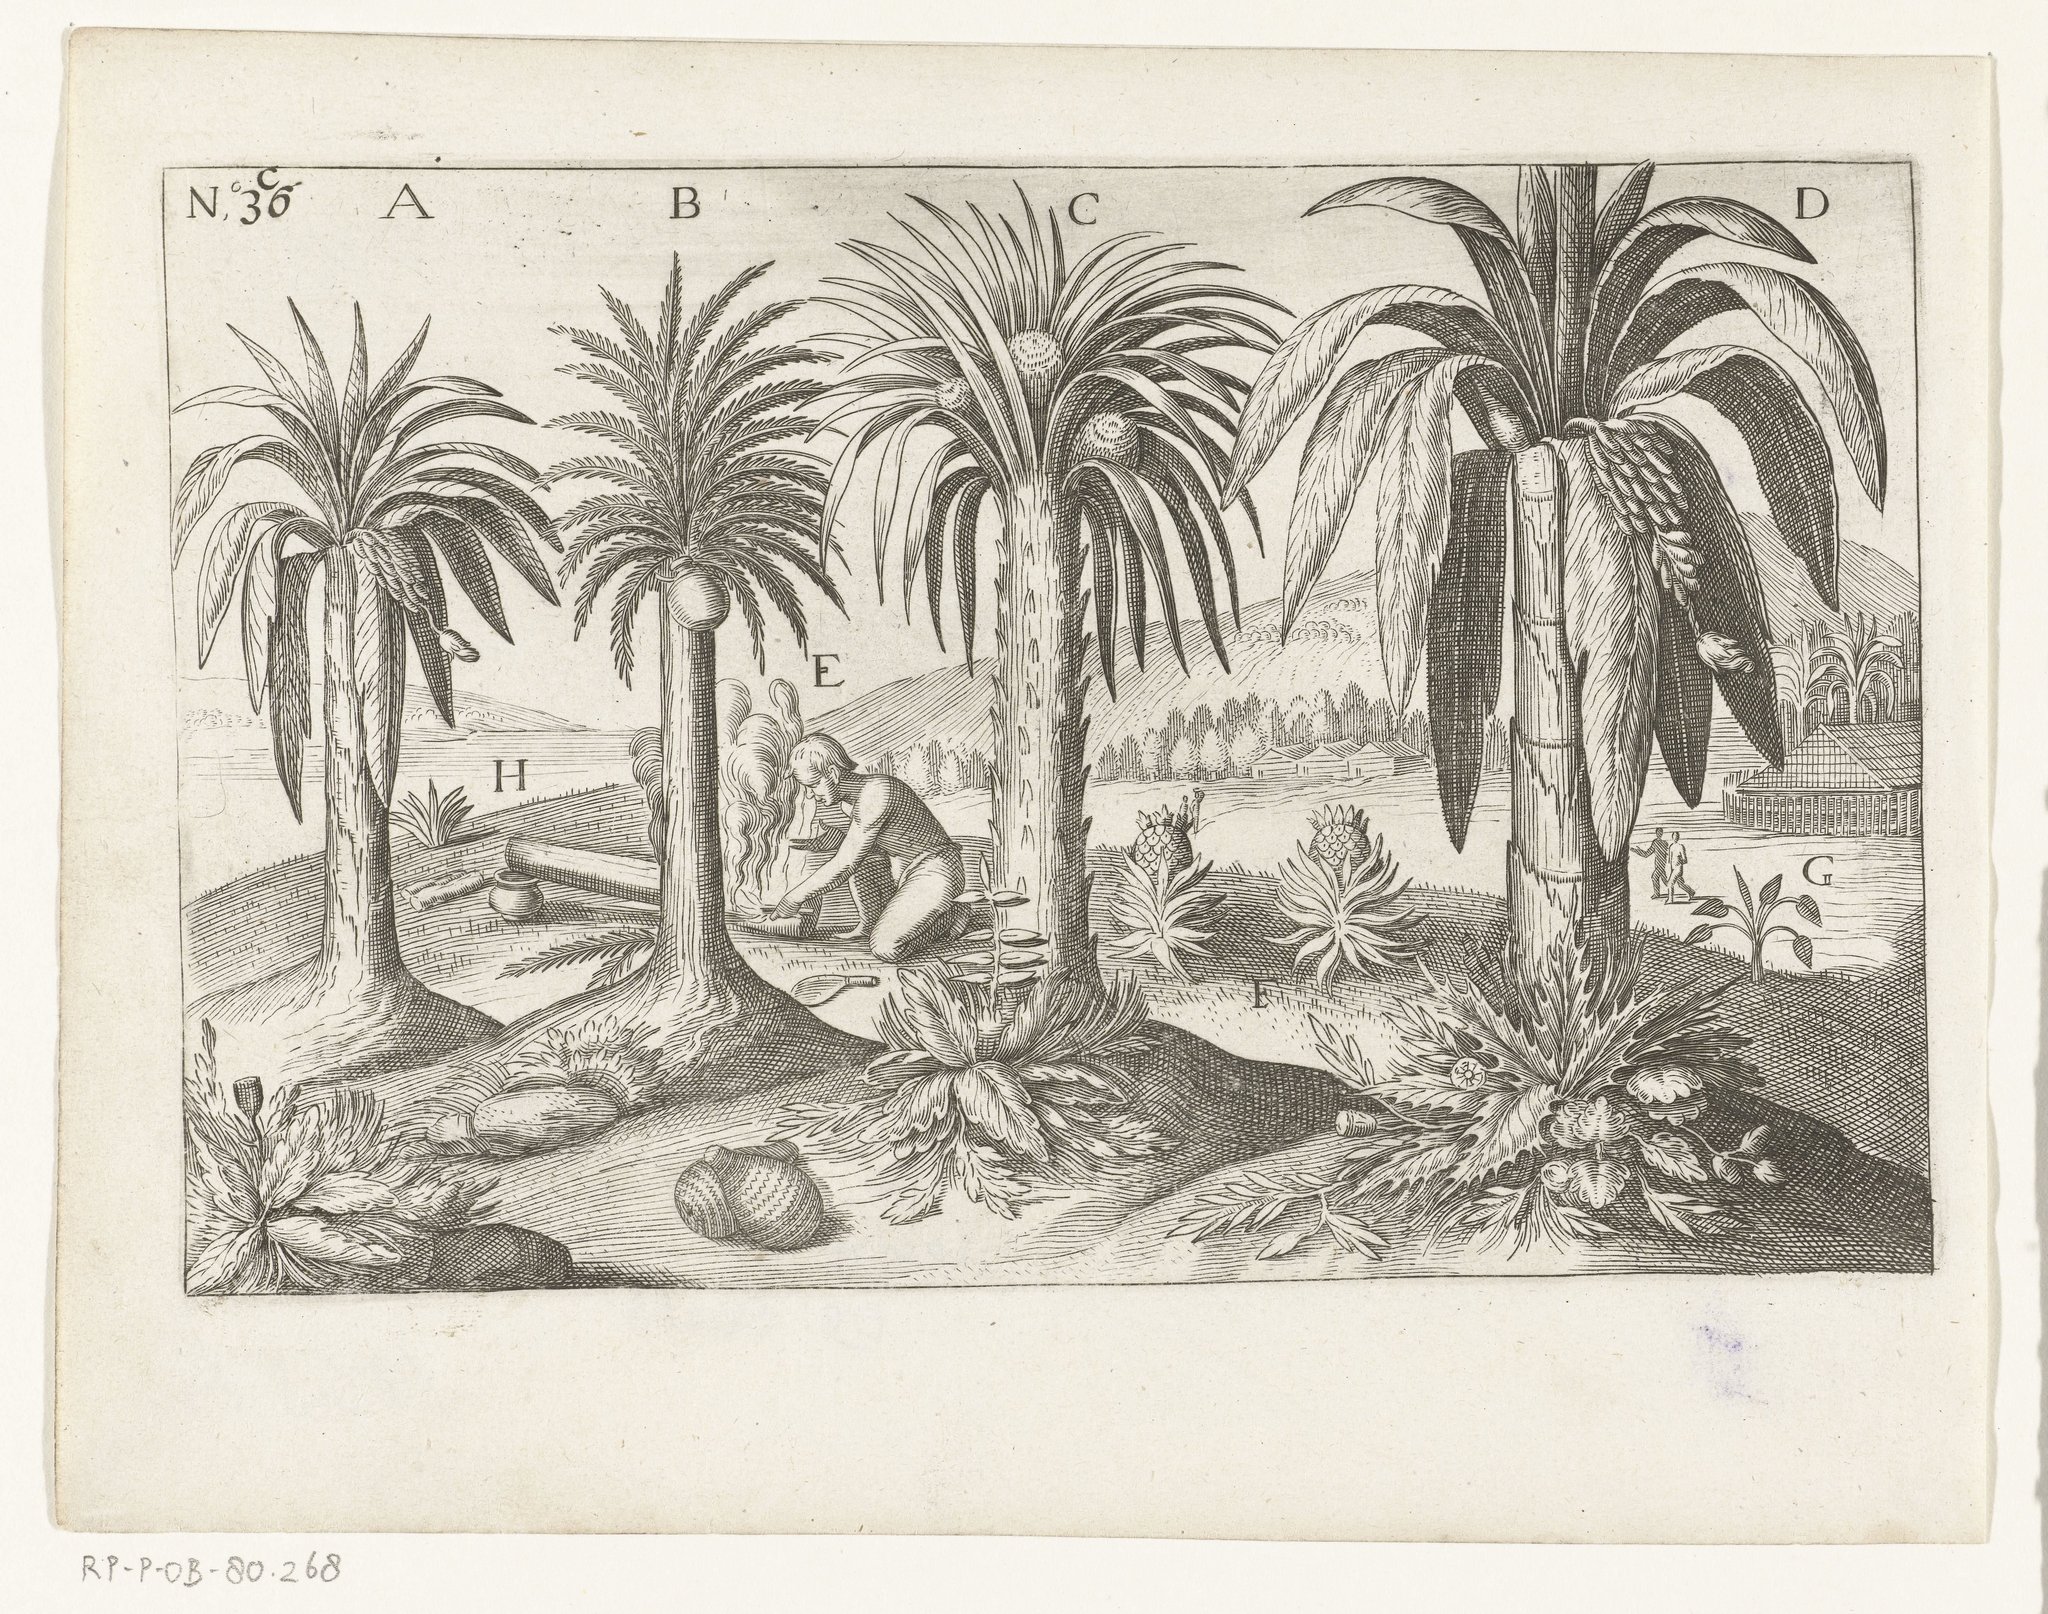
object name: print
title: Fruitbomen en kruiden op Java, 1596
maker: Anonymous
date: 1646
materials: paper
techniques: engraving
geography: northern netherlands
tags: gouda, plants; vegetation, landscapes in tropical and sub-tropical regions, exploration, expedition, voyage of discovery, java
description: Niet gebruikt als illustratie in: Willem Lodewijcksz, D'eerste boeck. Historie van Indien, waer inne verhaelt is de avontueren die de Hollandtsche schepen bejeghent zijn, Cornelis Claes, Amsterdam 1598. In deze opgewerkte staat gebruikt in: De Eerste Schipvaerd der Hollandsche Natie naer Oost-Indien, waer inne verhaelt wordt al wat haer sonderlings onder wegen bejegent is ... ghetrocken uyt verscheyden Iournalen ofte dagh-registers daer van ghemaeckt, zeer vermaeckelijck ende nut om lesen. Opgenomen in: I. Commelin, Begin ende voortgangh, van de Vereenighde Nederlantsche Geoctroyeerde Oost-Indische Compagnie, J. Janssonius, Amsterdam 1646. Genummerd: 36C.